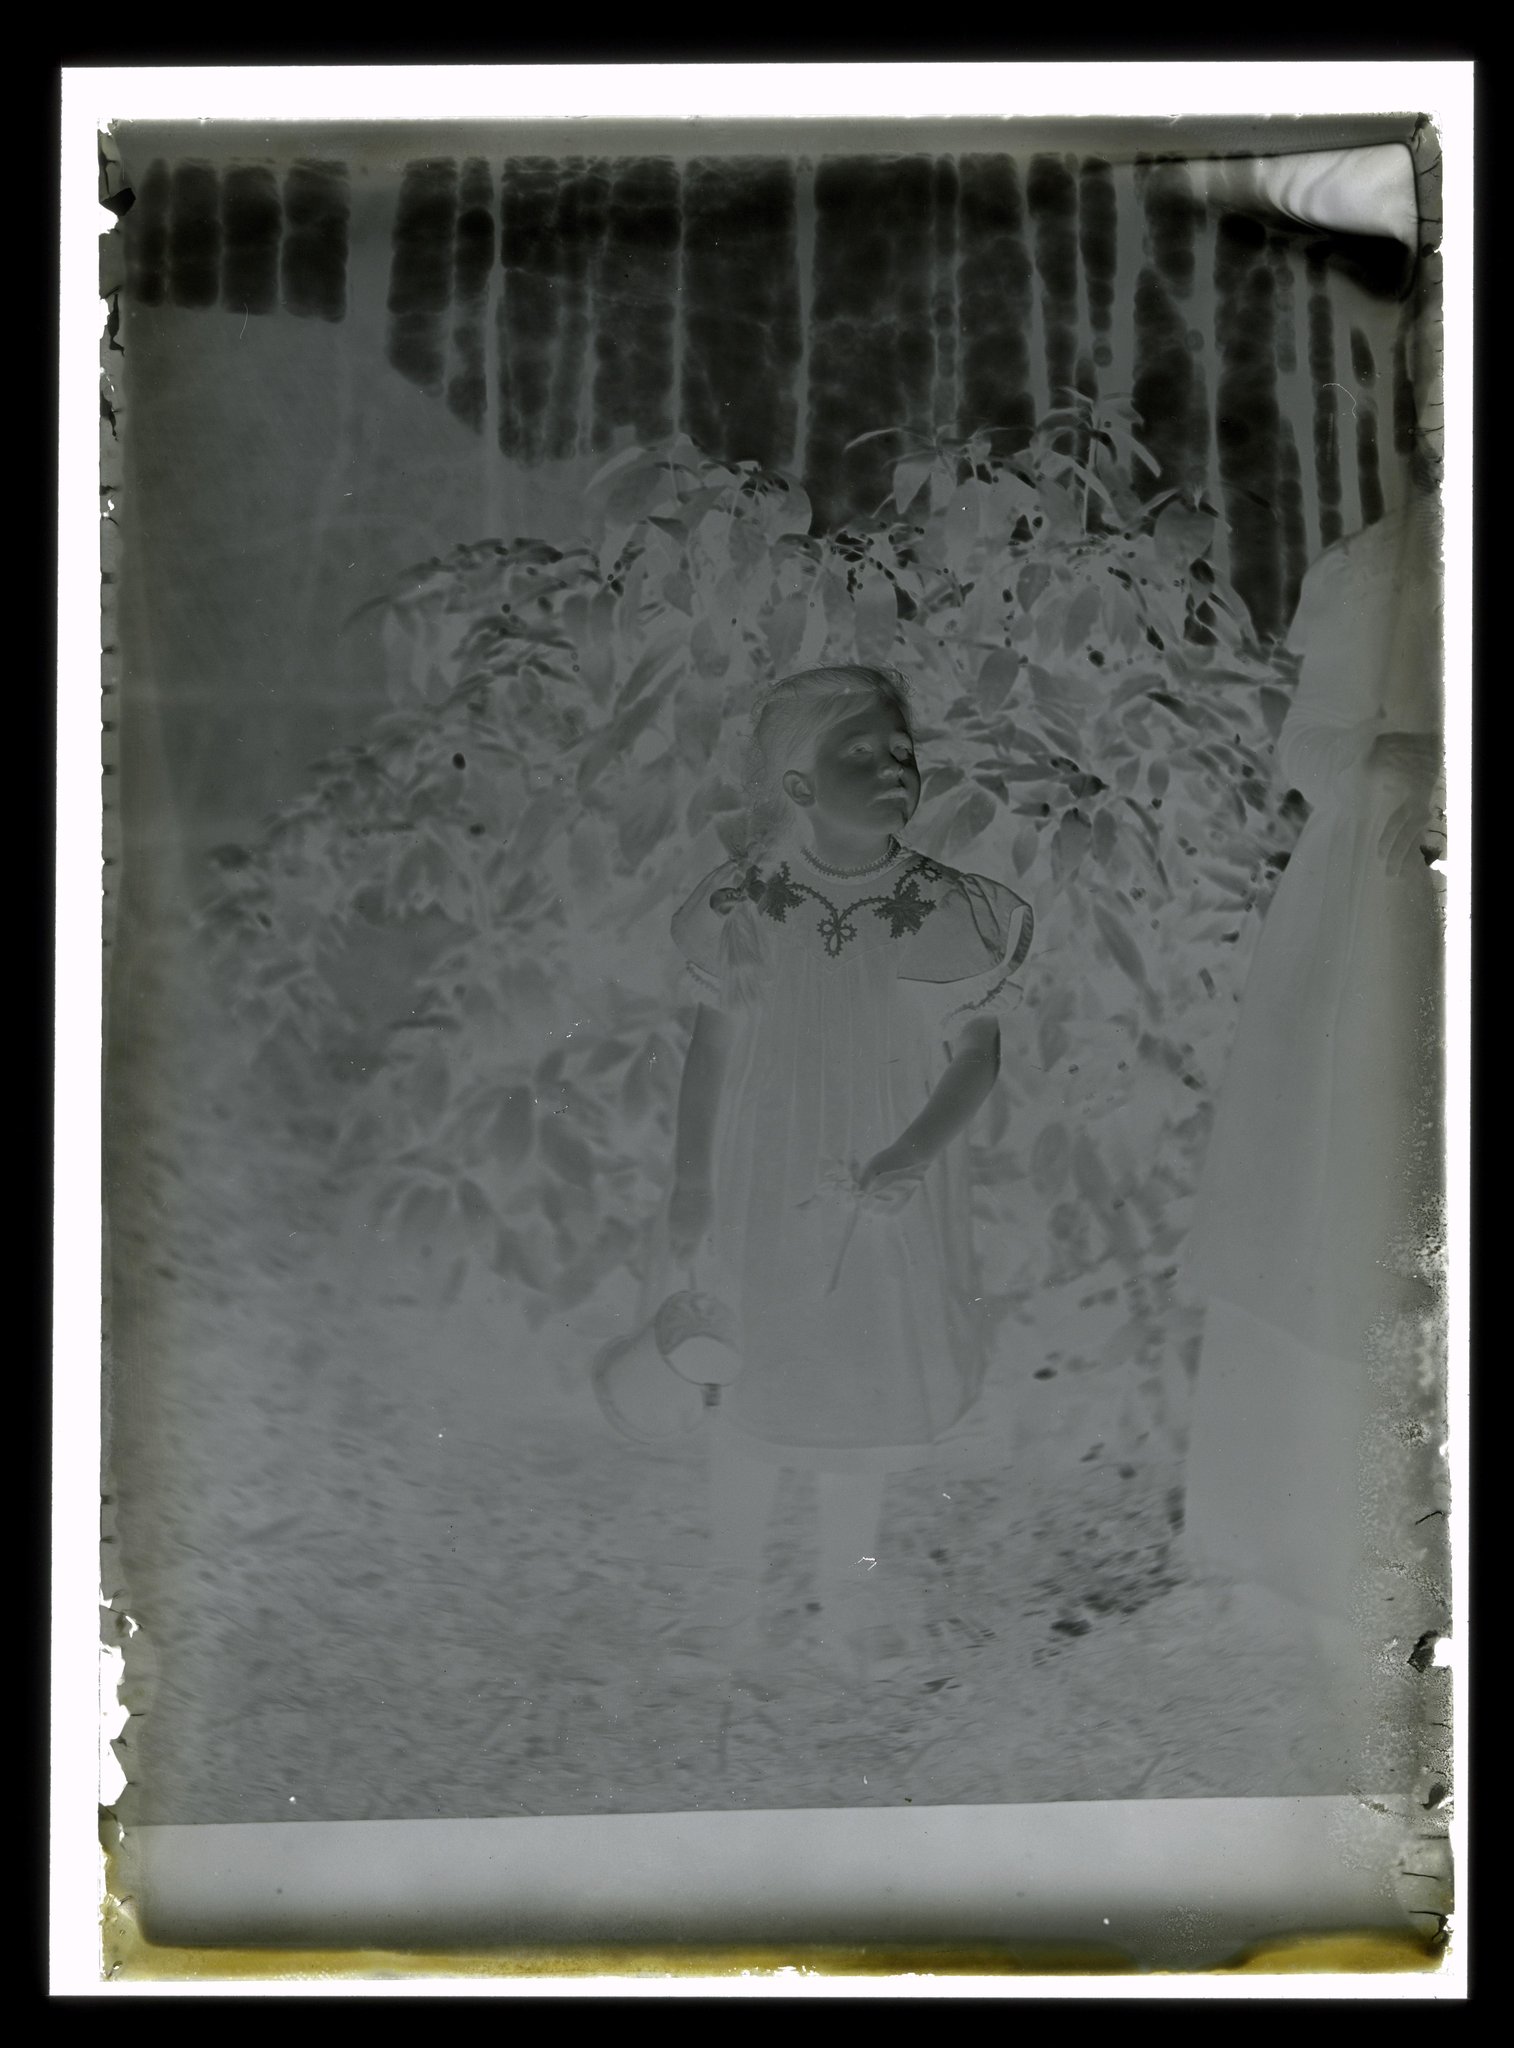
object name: glasnegatief, glasplaatnegatief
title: Meisje in een tuin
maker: laurens lodewijk kleijn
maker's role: draughtsman, painter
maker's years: 1826-1909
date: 1865-1900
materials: glass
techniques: collodion process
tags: girl (child between toddler and youth)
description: Onderdeel van een groep glasnegatieven uit de nalatenschap van de schilder Laurens Lodewijk Kleijn, met stillevens, portretten, zelfportretten en kunstreproducties.